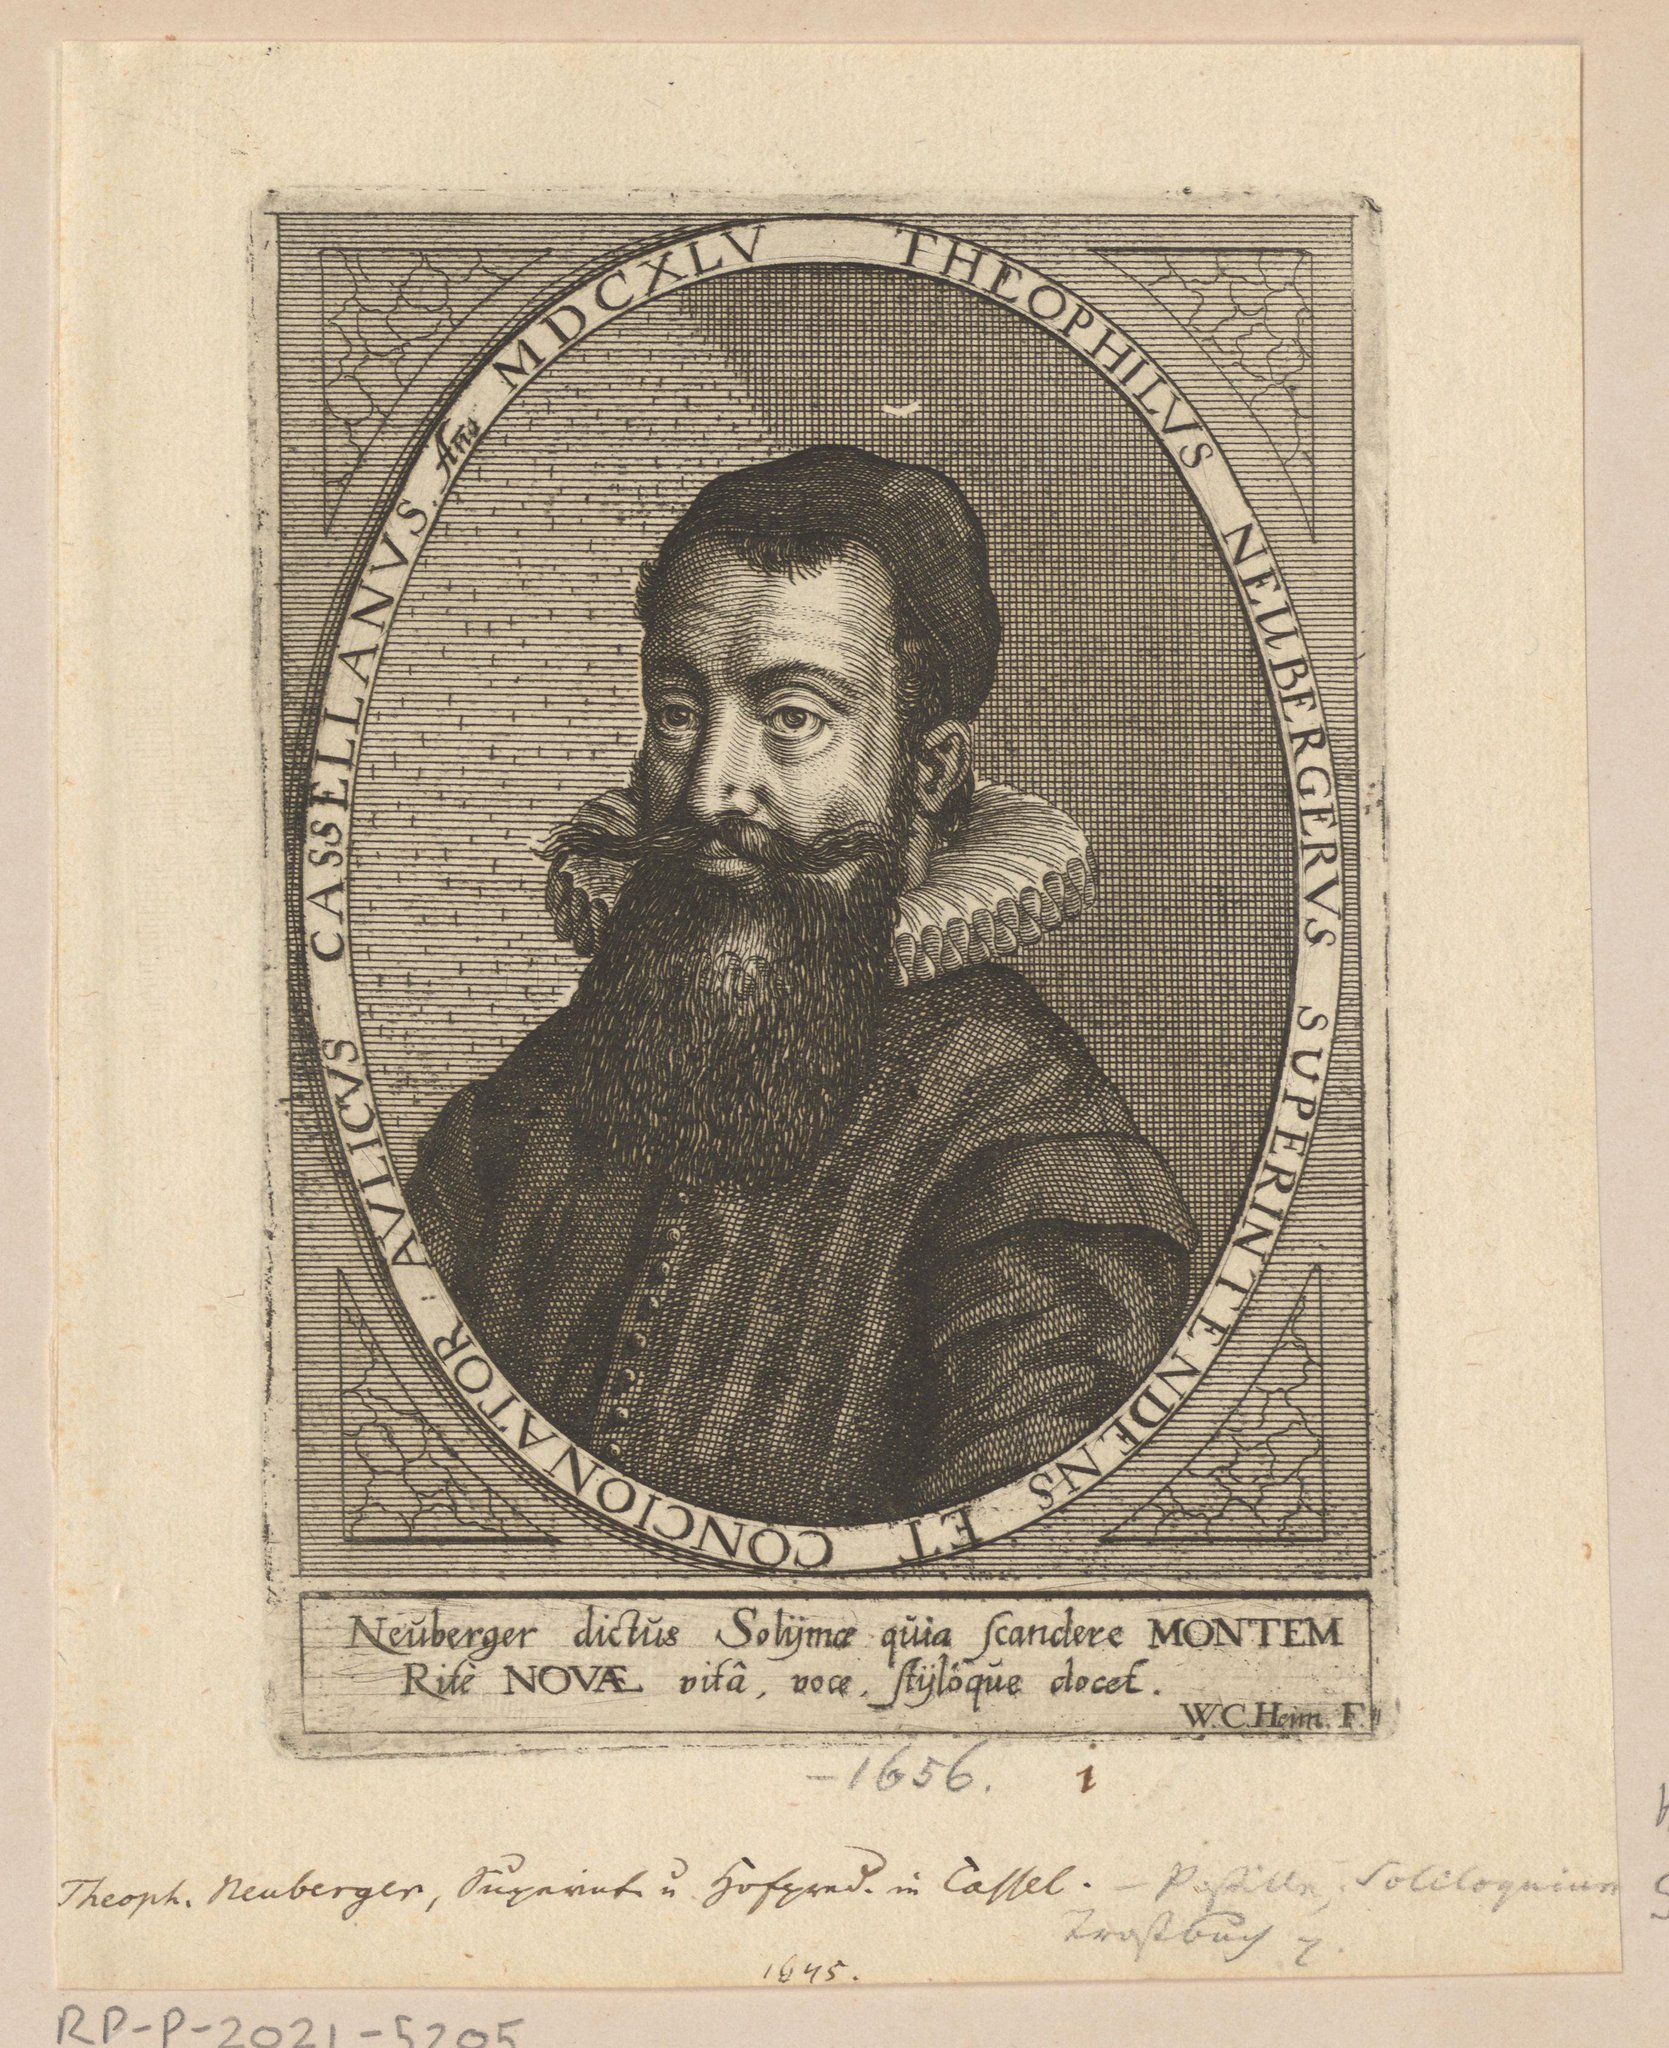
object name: print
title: Portret van Theophilus Neuberger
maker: w.c. heim (prentmaker)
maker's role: print maker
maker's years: 1610-1656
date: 1645-1650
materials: paper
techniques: engraving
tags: theologian, historical persons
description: Latere staat van prent gebruikt in: Boissard, Jean Jacques. Bibliotheca chalcographica (...) VIII pars. Frankfurt am Main: Johannes Ammon, 1650, dl 6.